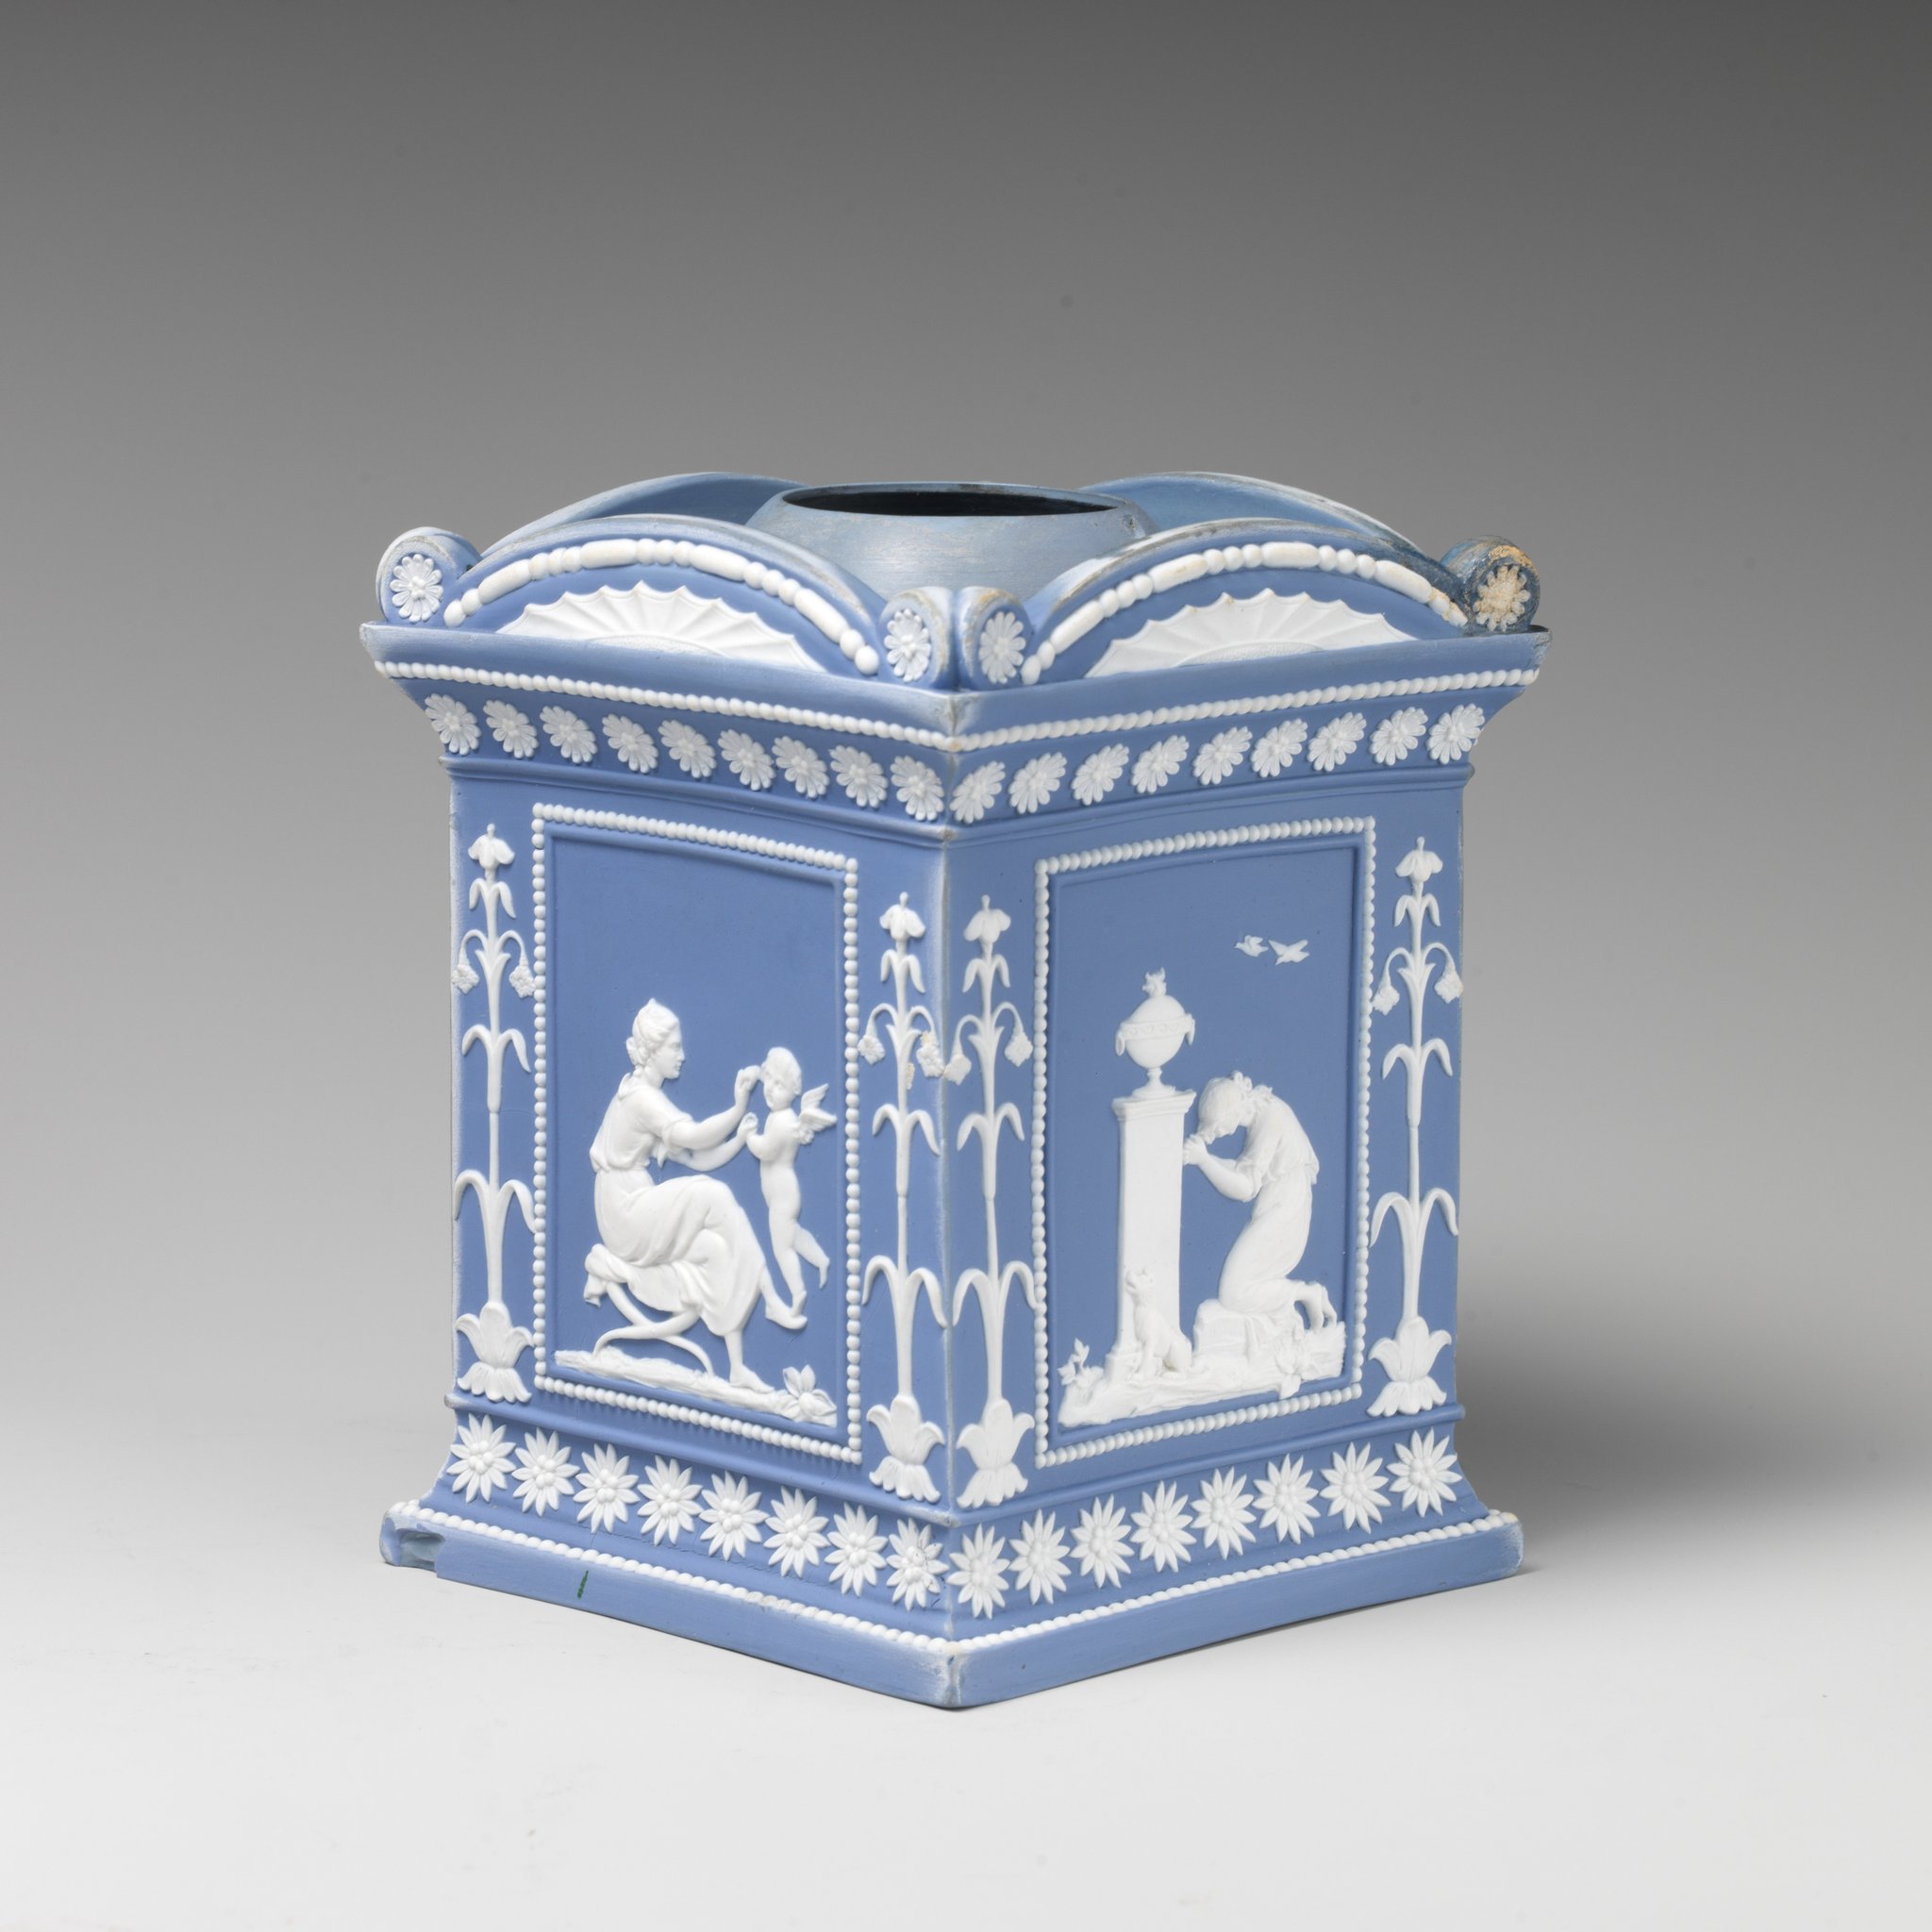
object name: pedestal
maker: john turner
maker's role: artist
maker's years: 1762-1786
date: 1701-1800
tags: children,girls,women